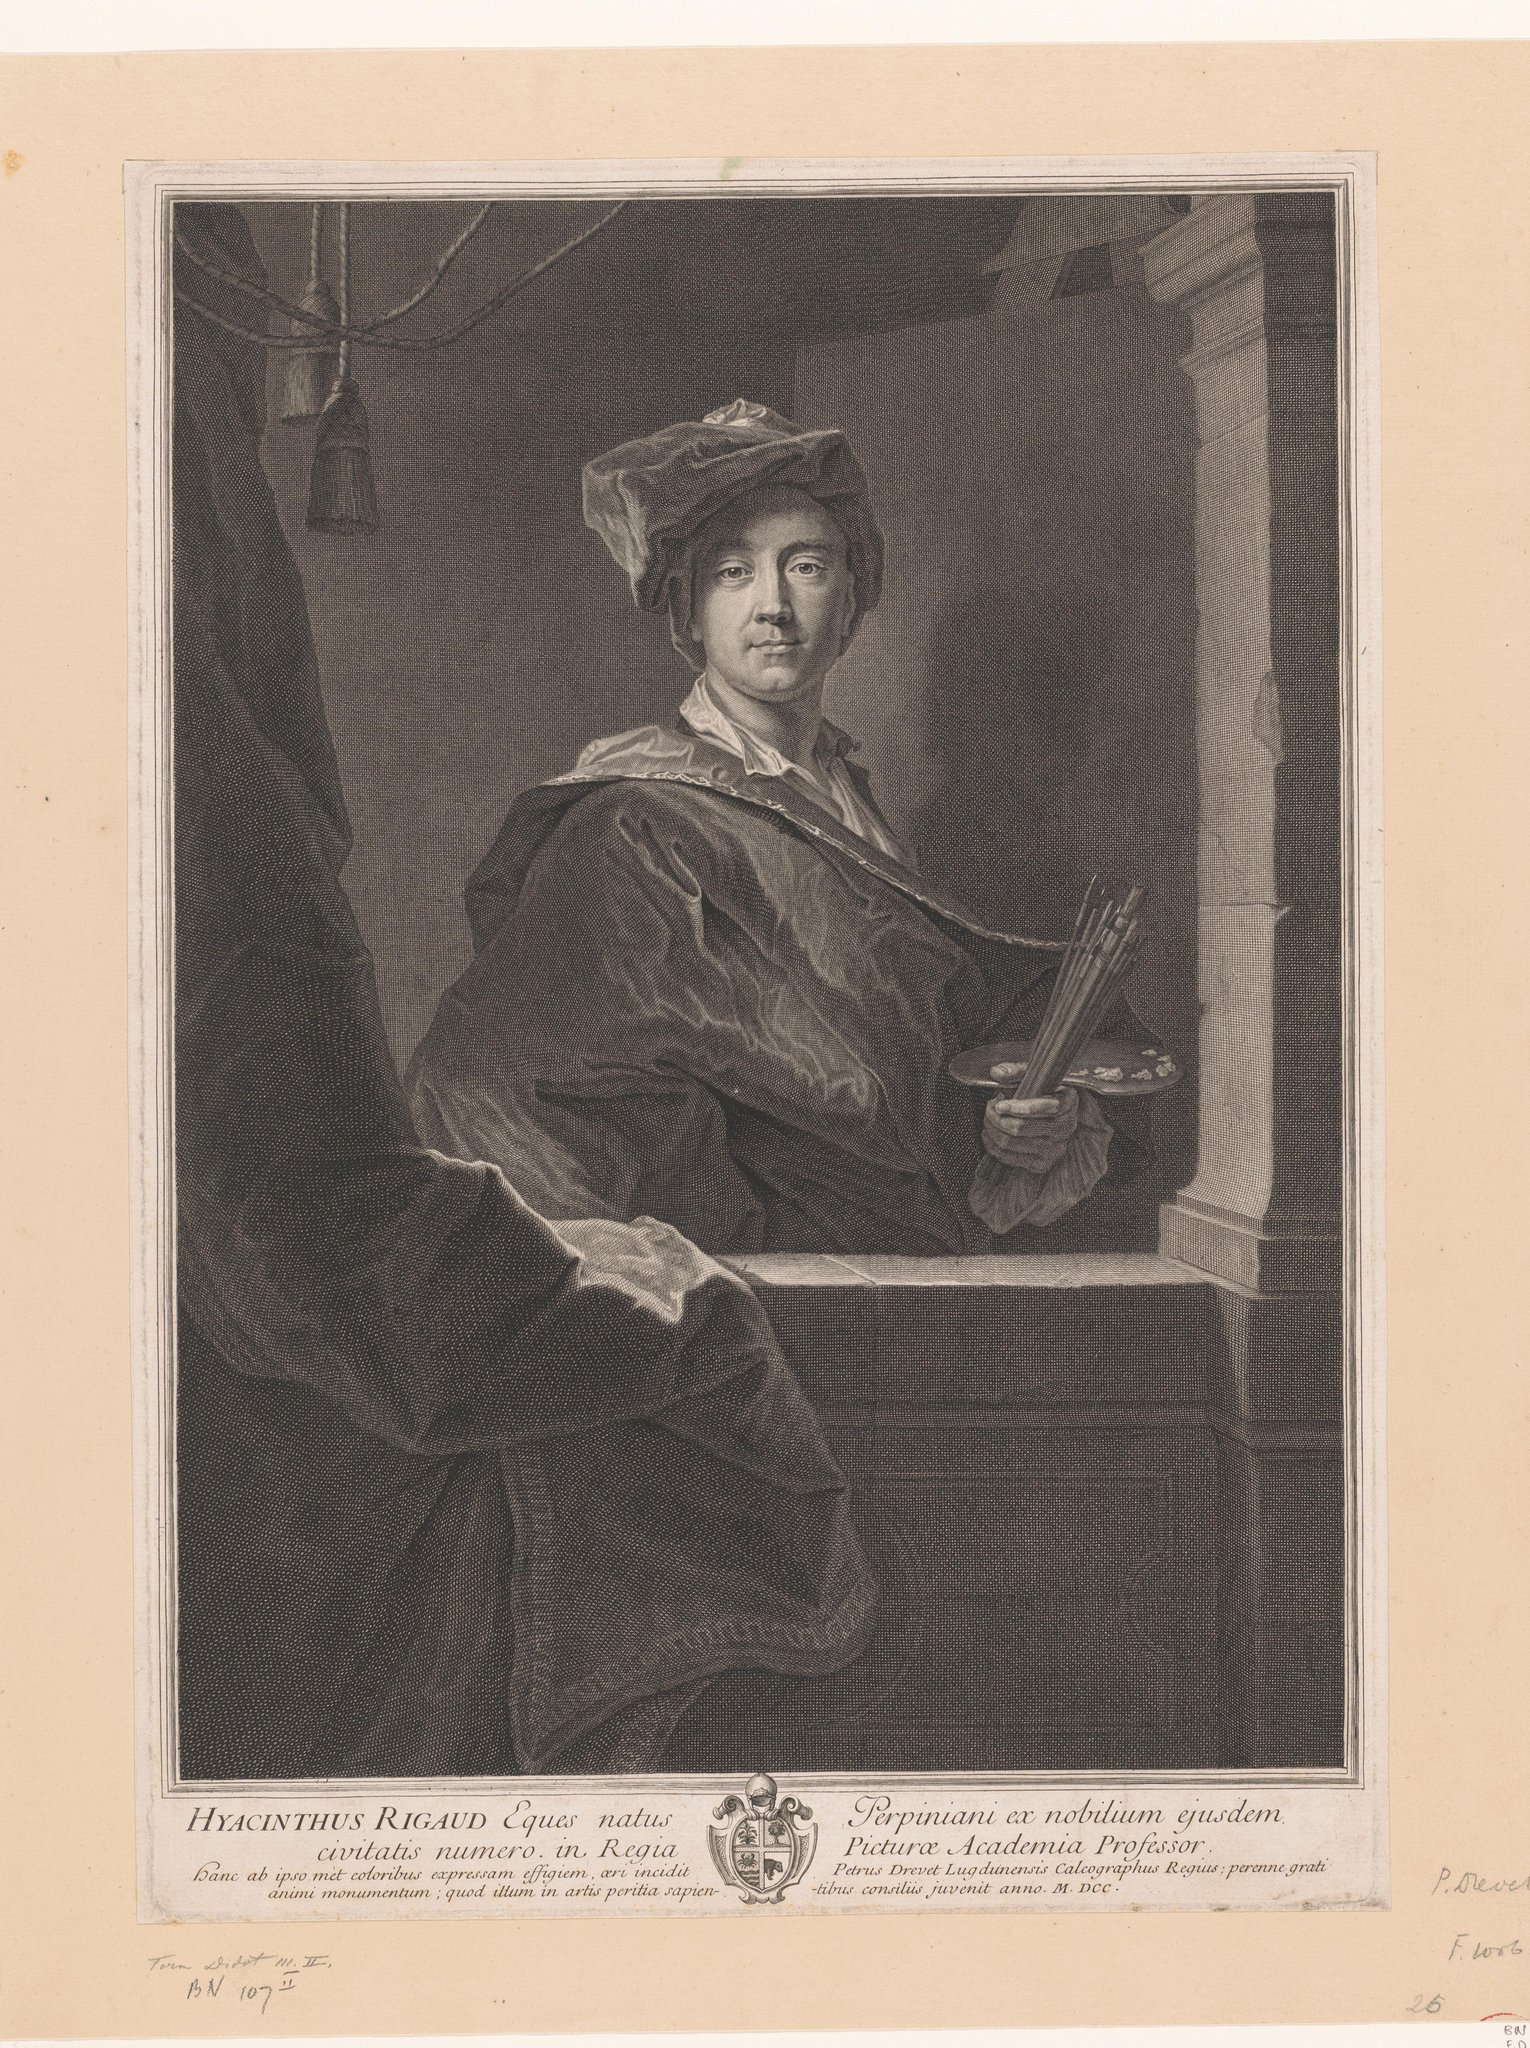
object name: print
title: Portret van Hyacinthe Rigaud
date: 1714-1721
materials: paper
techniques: engraving, etching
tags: paris, painter, draughtsman, hyacinthe rigaud, historical persons, portrait, self-portrait of painter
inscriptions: collector's mark: Lugt 240